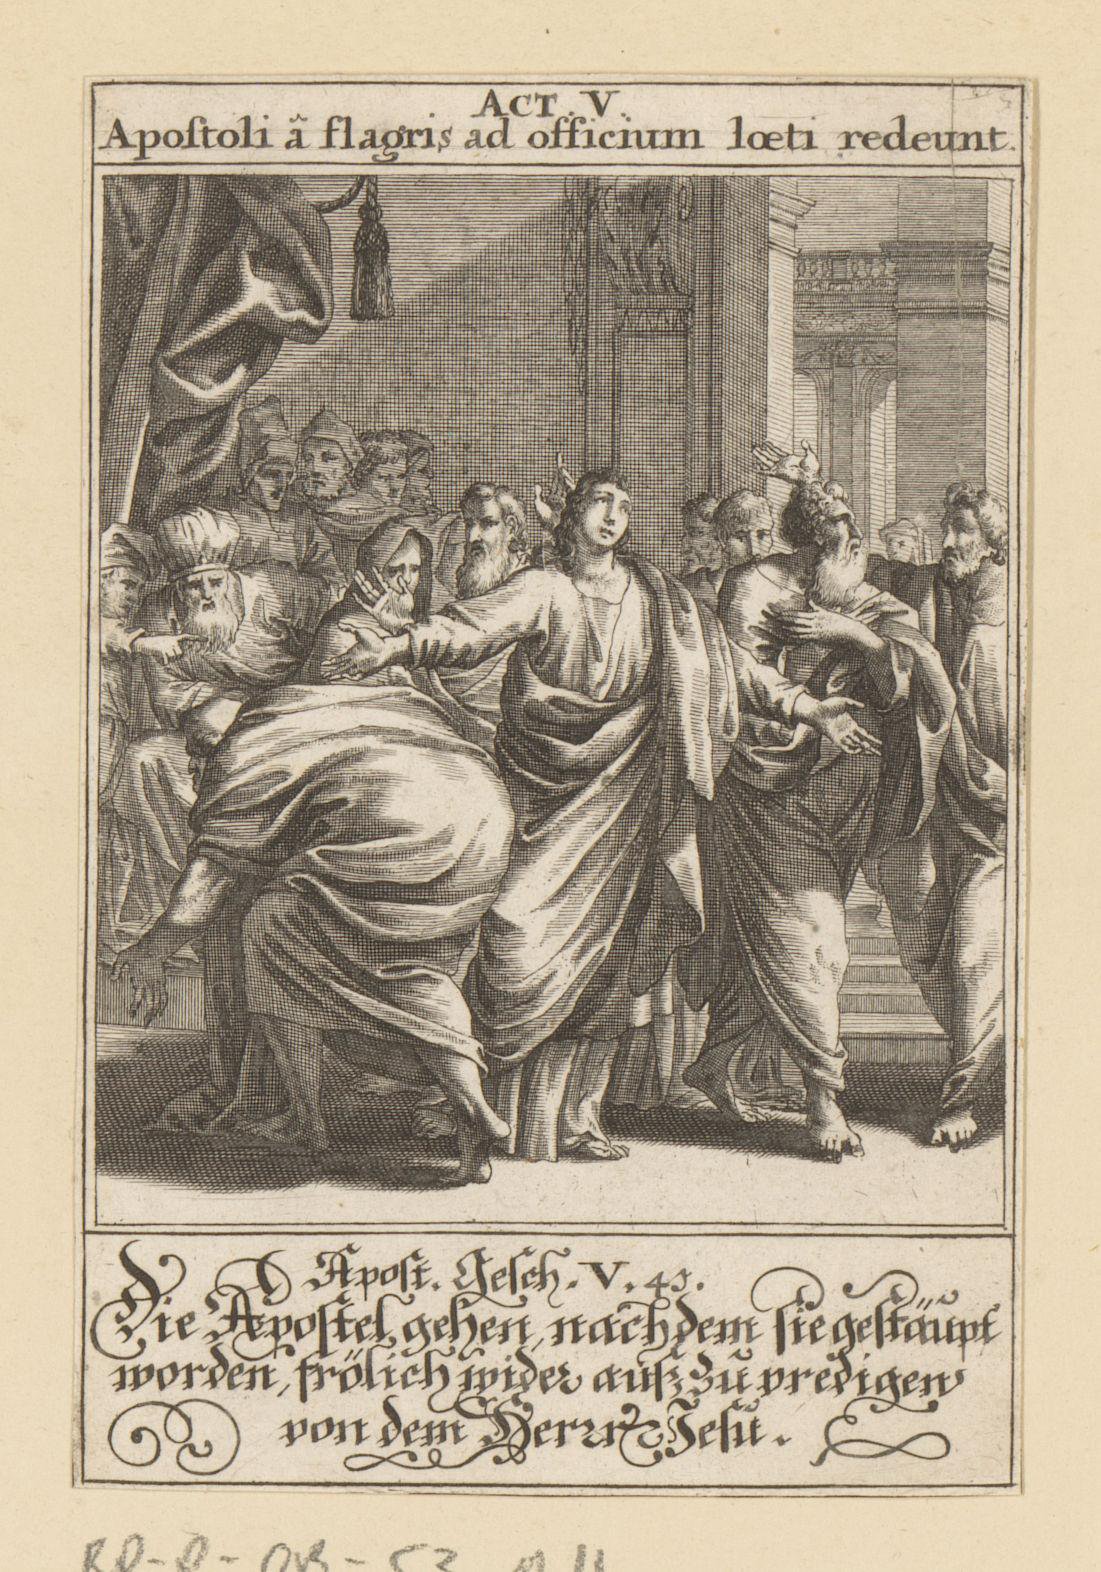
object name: print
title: Apostelen gaan weer prediken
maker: Anonymous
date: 1697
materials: paper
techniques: etching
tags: in the morning officers find the doors of the prison closed and the apostles gone; they are preaching again in the temple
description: Prent ook gebruikt in: Biblia ectypa : Bildnussen auss Heiliger Schrifft. Regensburg: Chr. Wiegel, 1697.